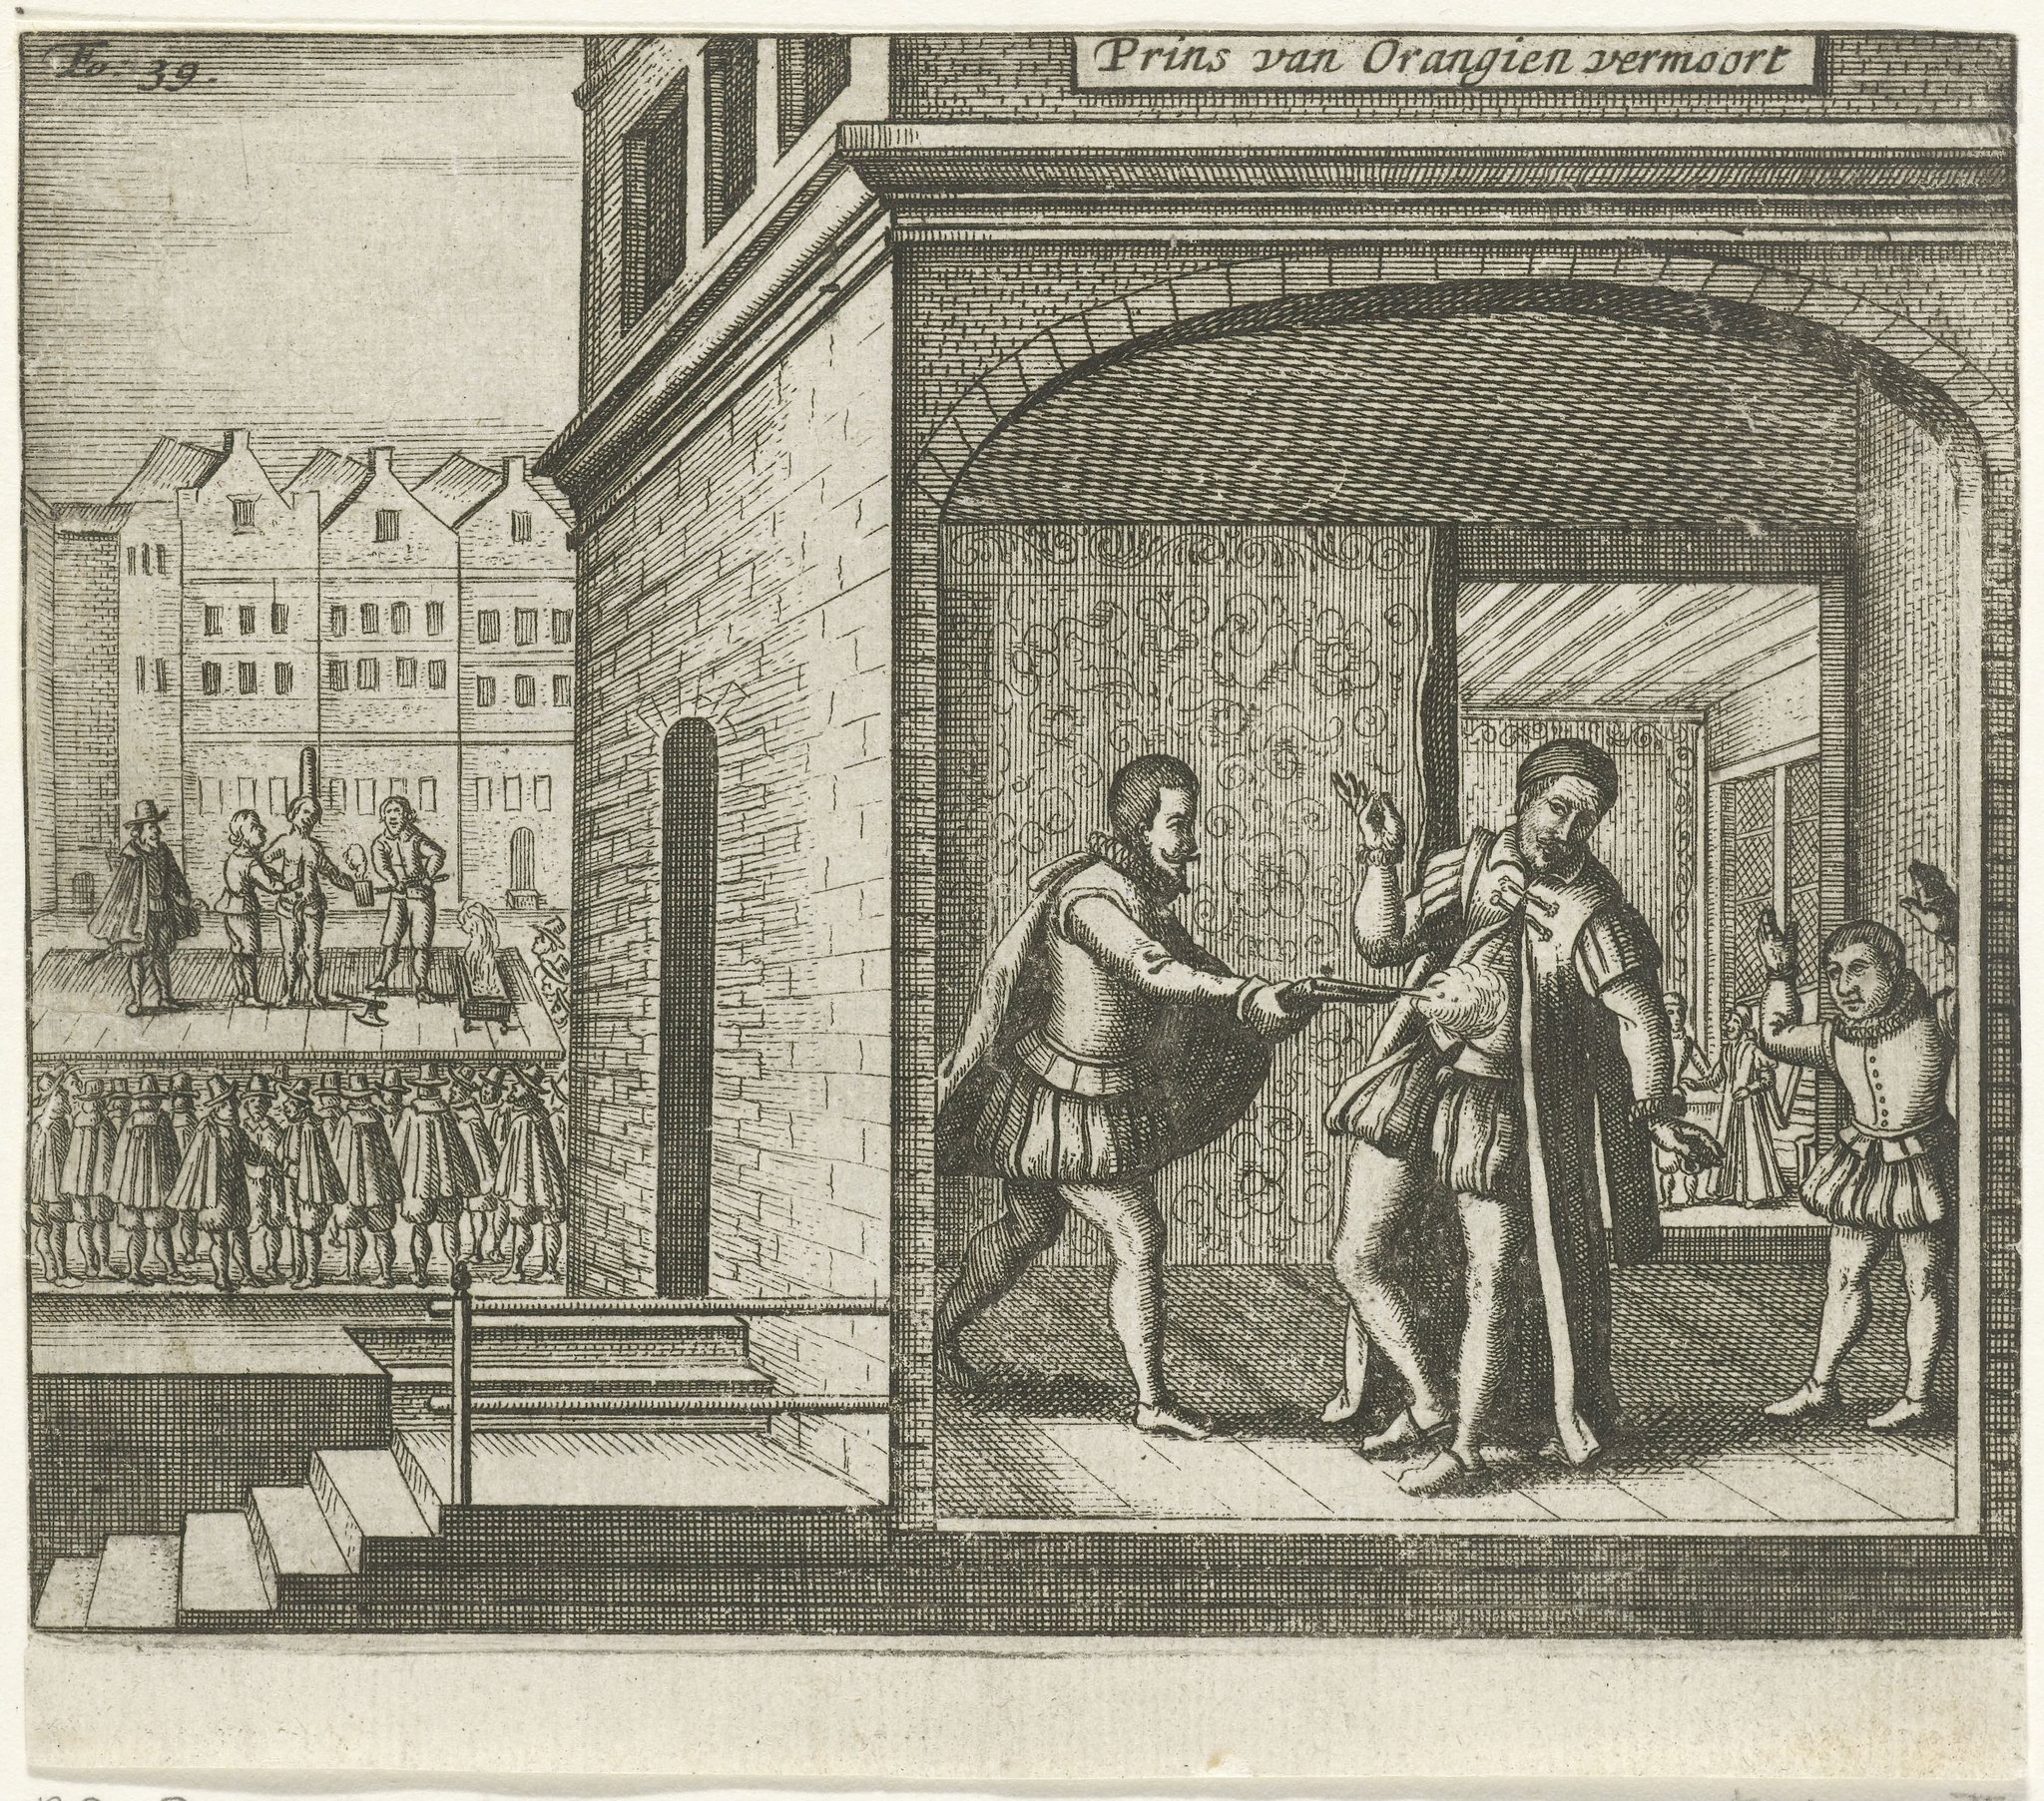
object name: history print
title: Moord op de prins van Oranje, 1584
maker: Anonymous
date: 1620-1699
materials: paper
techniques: etching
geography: northern netherlands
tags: delft, william i (prince of orange), on the scaffold or place of execution, attempt, political murder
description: Kopie naar RP-P-OB-79.917, de anonieme illustratie voor een (onbekende) uitgave van het populaire en vaak herdrukte werk getiteld: De Spaensche Tiranye gheschiet in Nederlant, waarschijnlijk voor het eerst ca. 1620 verschenen. Niet in Frederik Muller; door het RPK toegevoegd nummer.